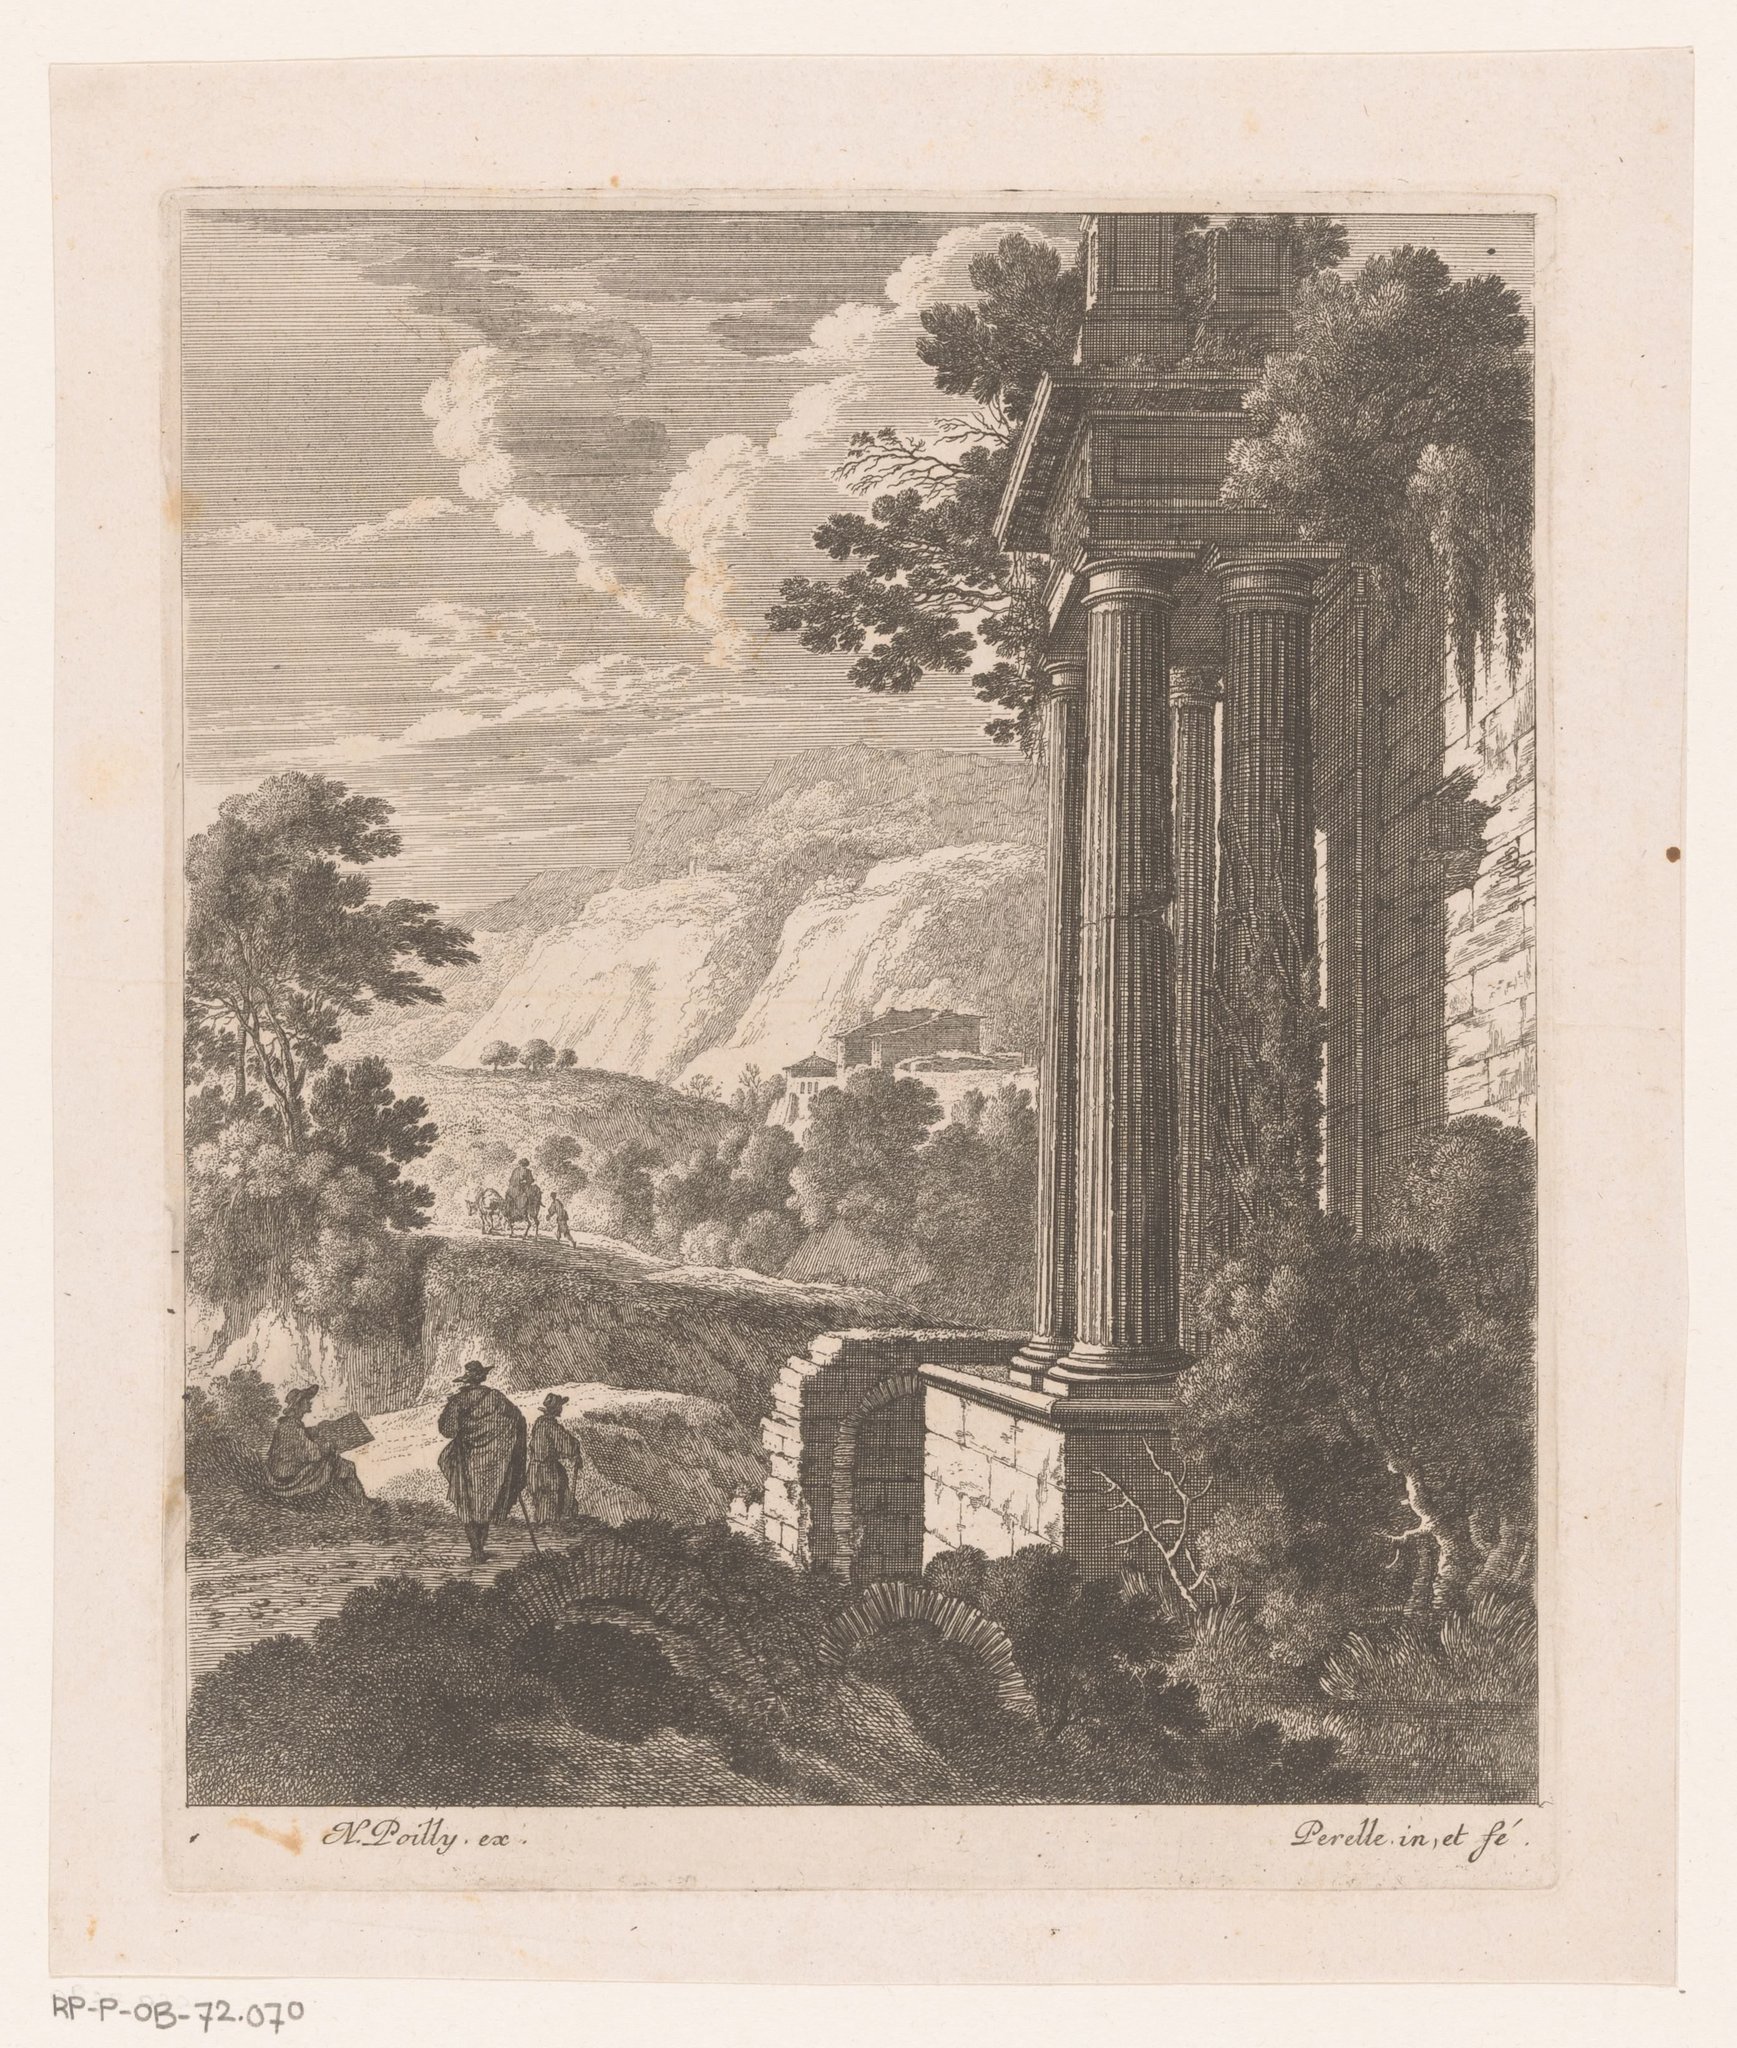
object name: print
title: Landschap met ruïne van antieke tempel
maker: nicolas de poilly (i)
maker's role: print maker, publisher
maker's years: 1626-1696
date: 1636-1695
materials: paper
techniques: engraving, etching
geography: paris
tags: column, pillar ~ architecture, landscape with ruins, temple, shrine ~ roman religion, artist at work, in his workshop - bb - out of doors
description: Prenten met het signatuur 'Perelle' kunnen zowel door vader Gabriel als door zonen Nicolas en Adam gemaakt zijn.